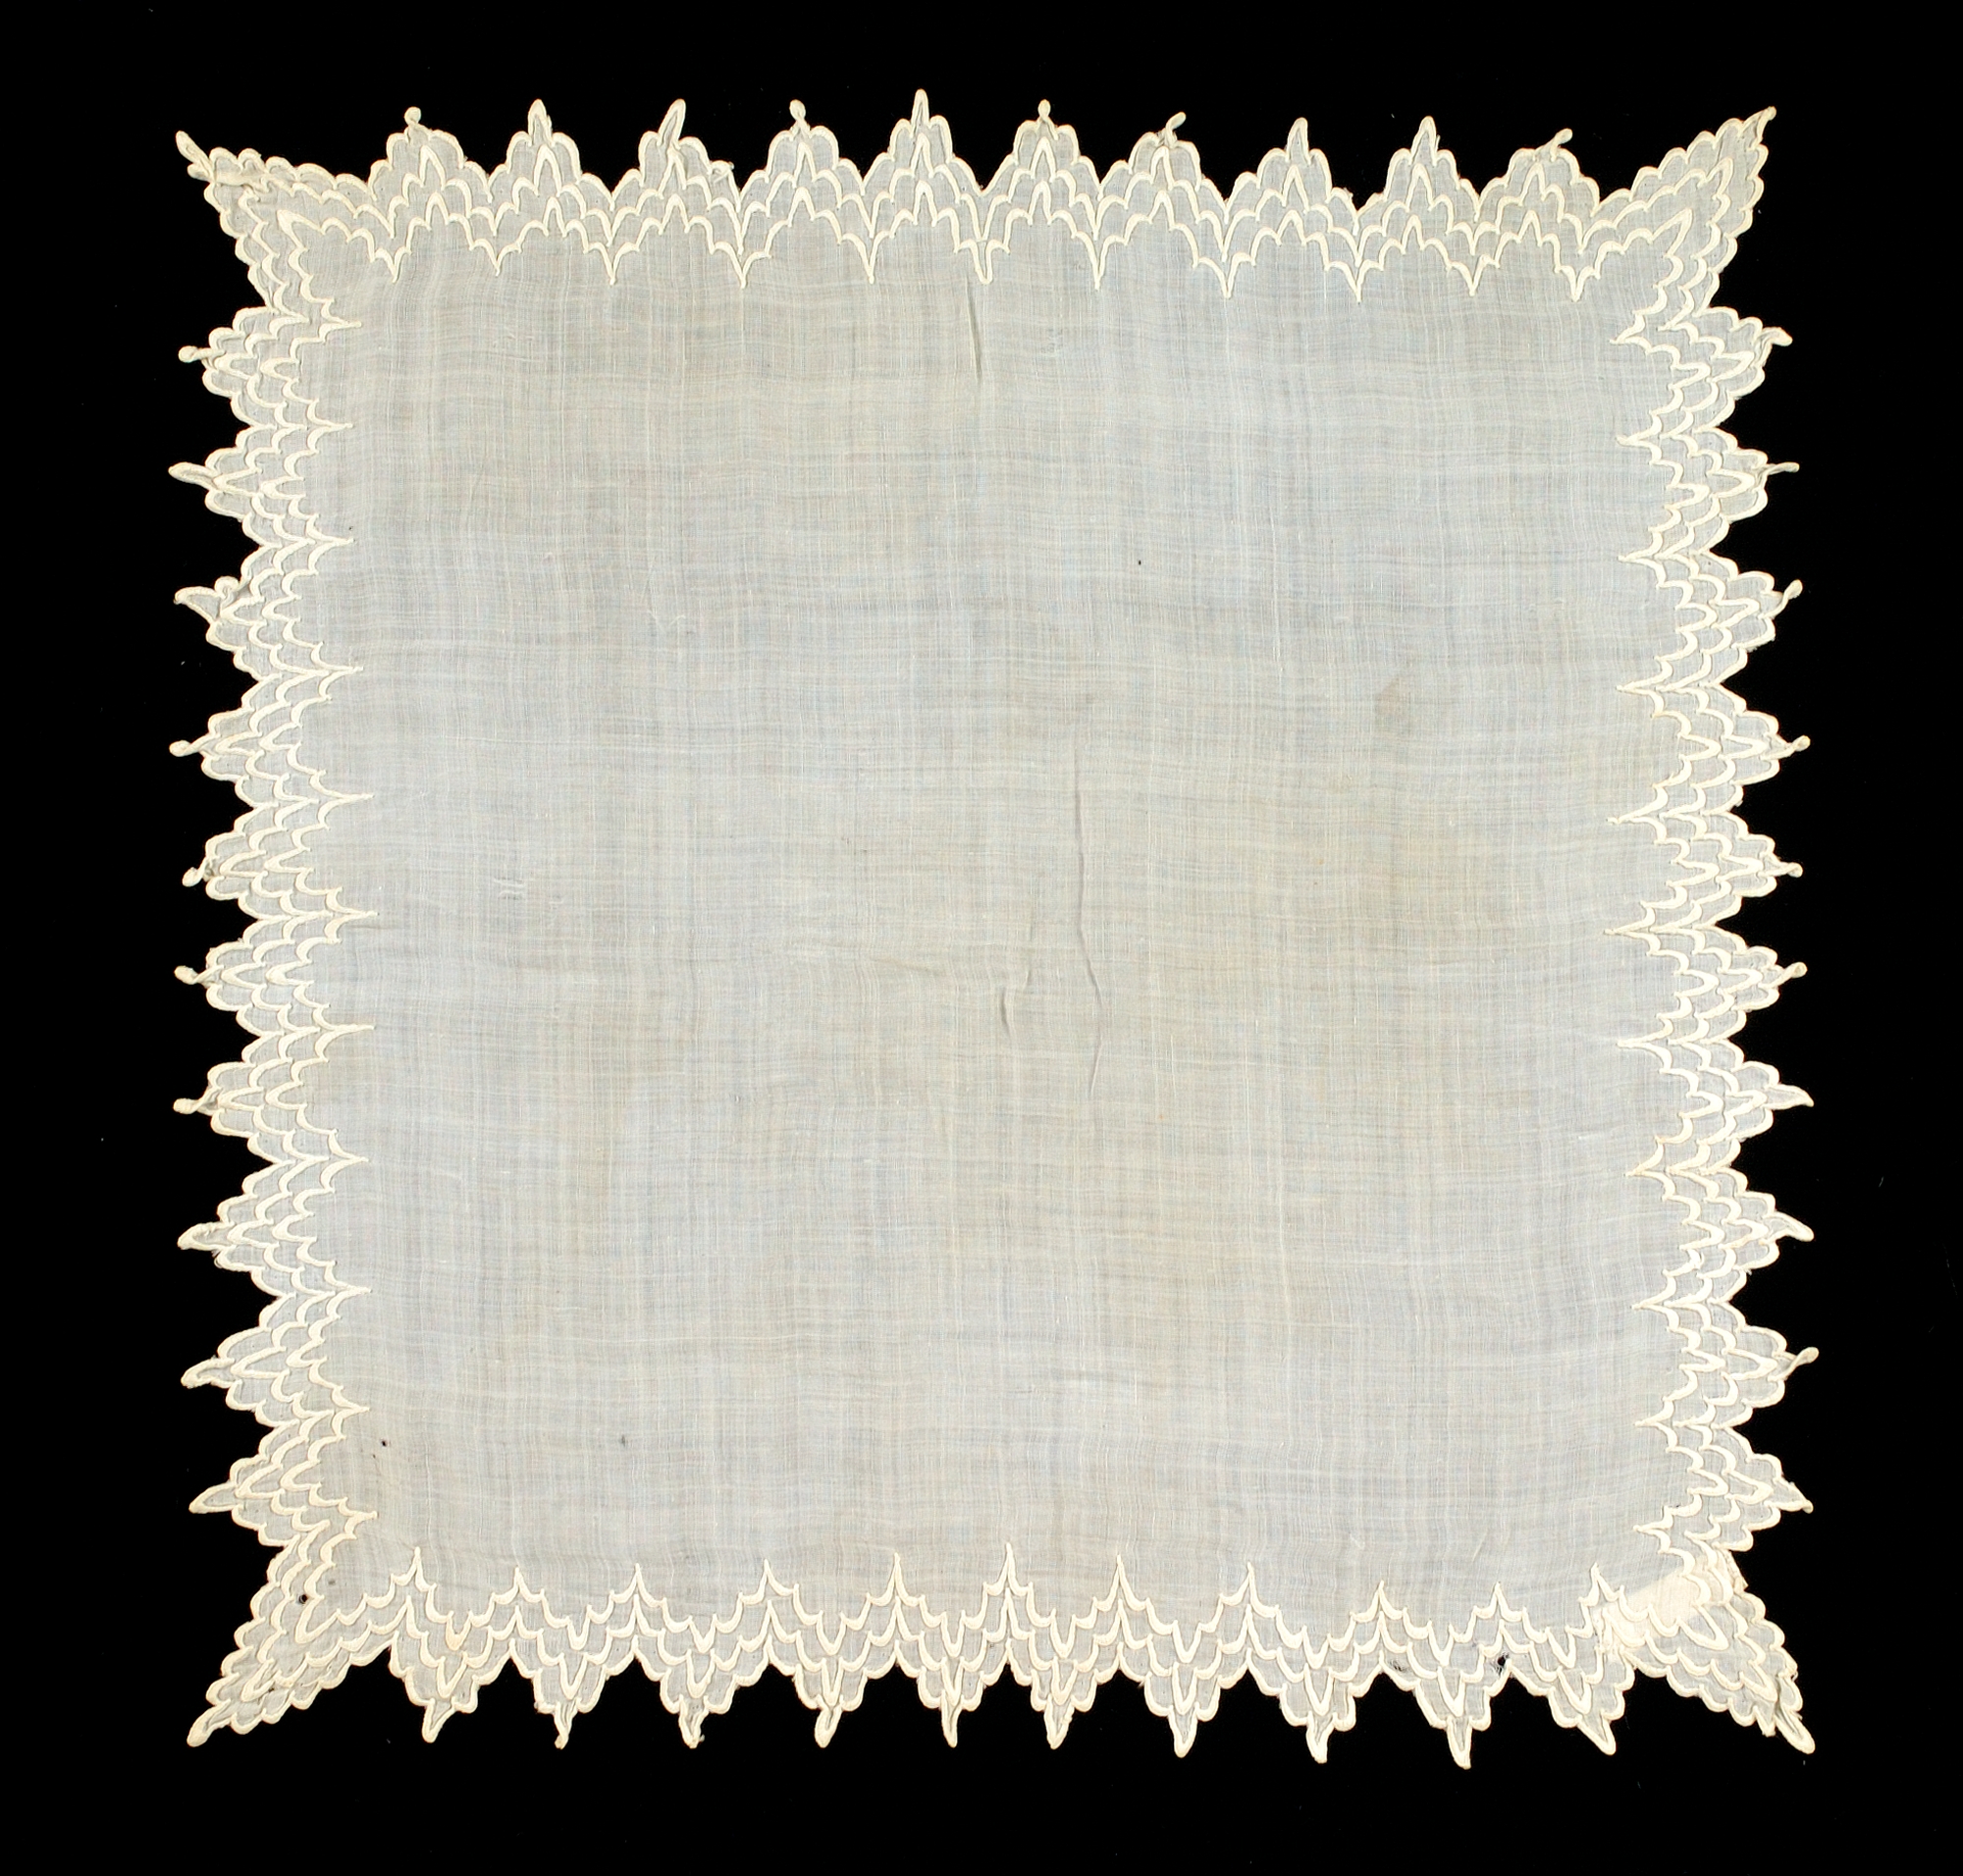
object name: handkerchief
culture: american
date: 1830-1850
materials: cotton